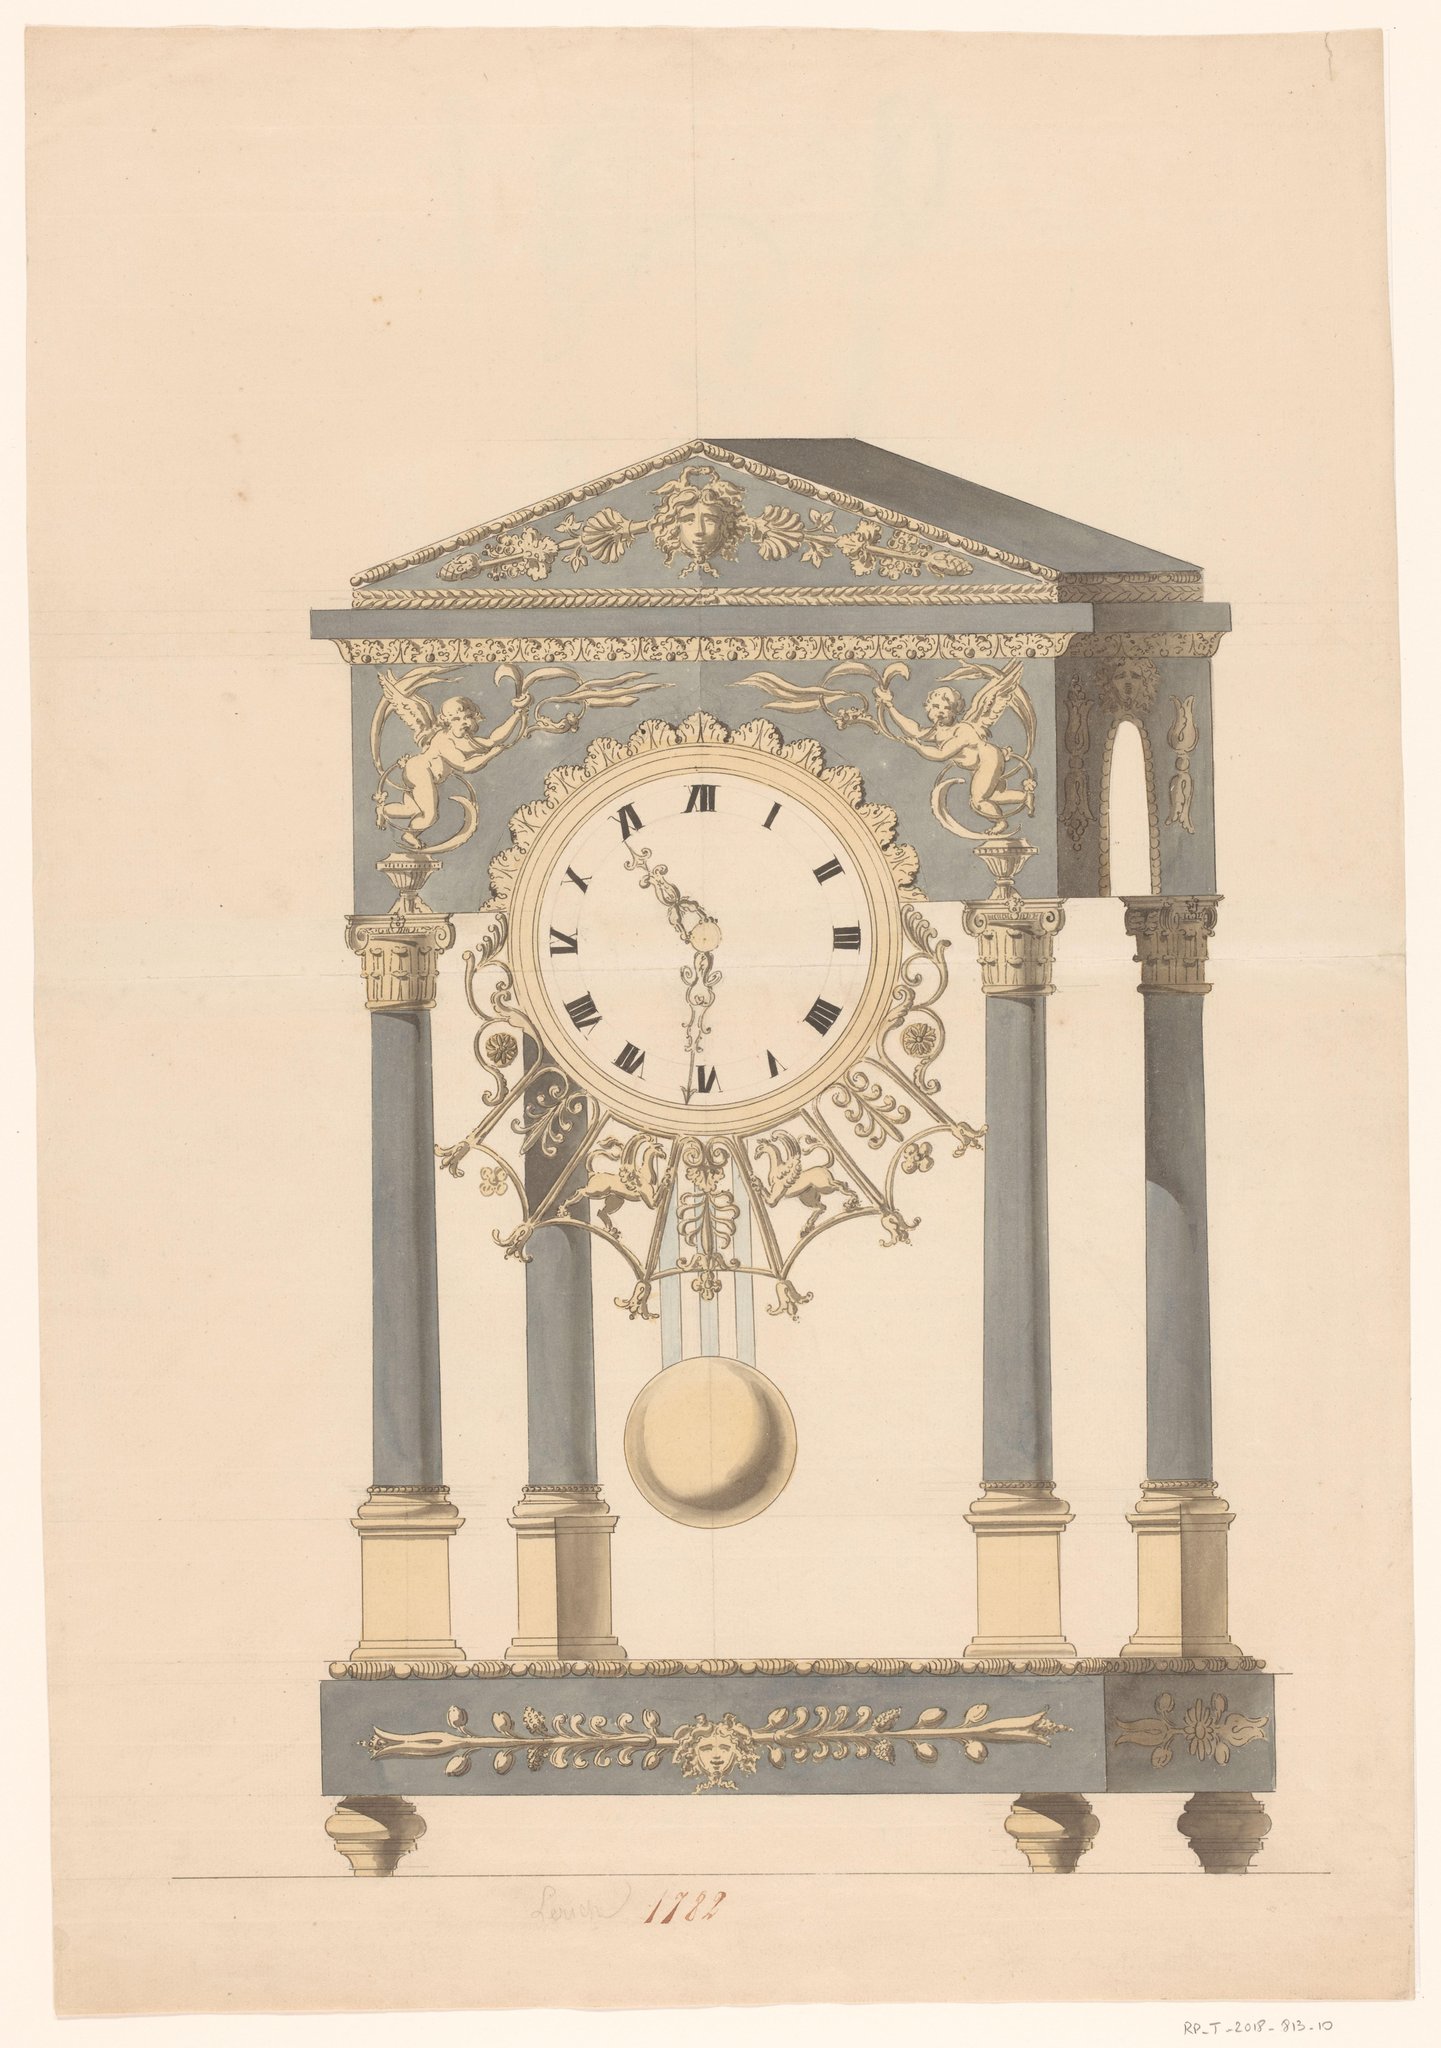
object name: design drawing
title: Pendule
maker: Anonymous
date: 1800-1820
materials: graphite, ink, paper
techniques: brush, pen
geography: paris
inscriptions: inscription: ‘N 41 Eaux Fortes (aqua forte) Prix divers’, watermark: ‘VAN DER LEY en Fortuna op bol, rustend op een podium met daaronder VDL (VD aaneen).’, date: ‘1782’, inscription: ‘Leriche’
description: Pendule van gepatineerd en verguld brons in de vorm van een portiek met een fronton.